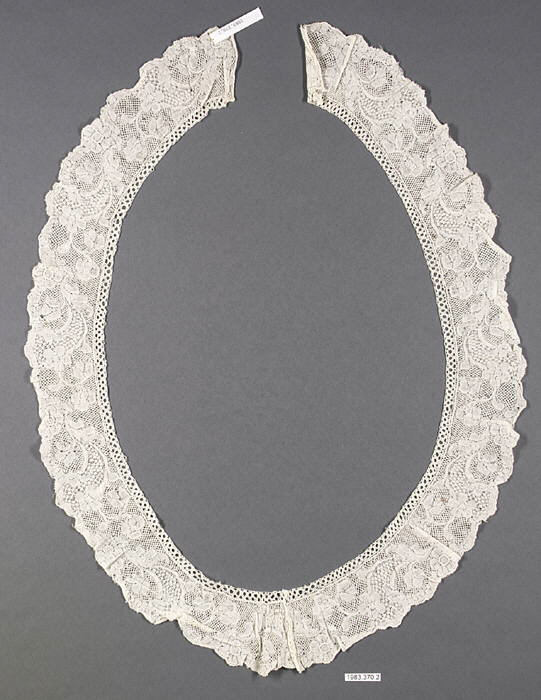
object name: edging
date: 1701-1800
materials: linen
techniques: lace